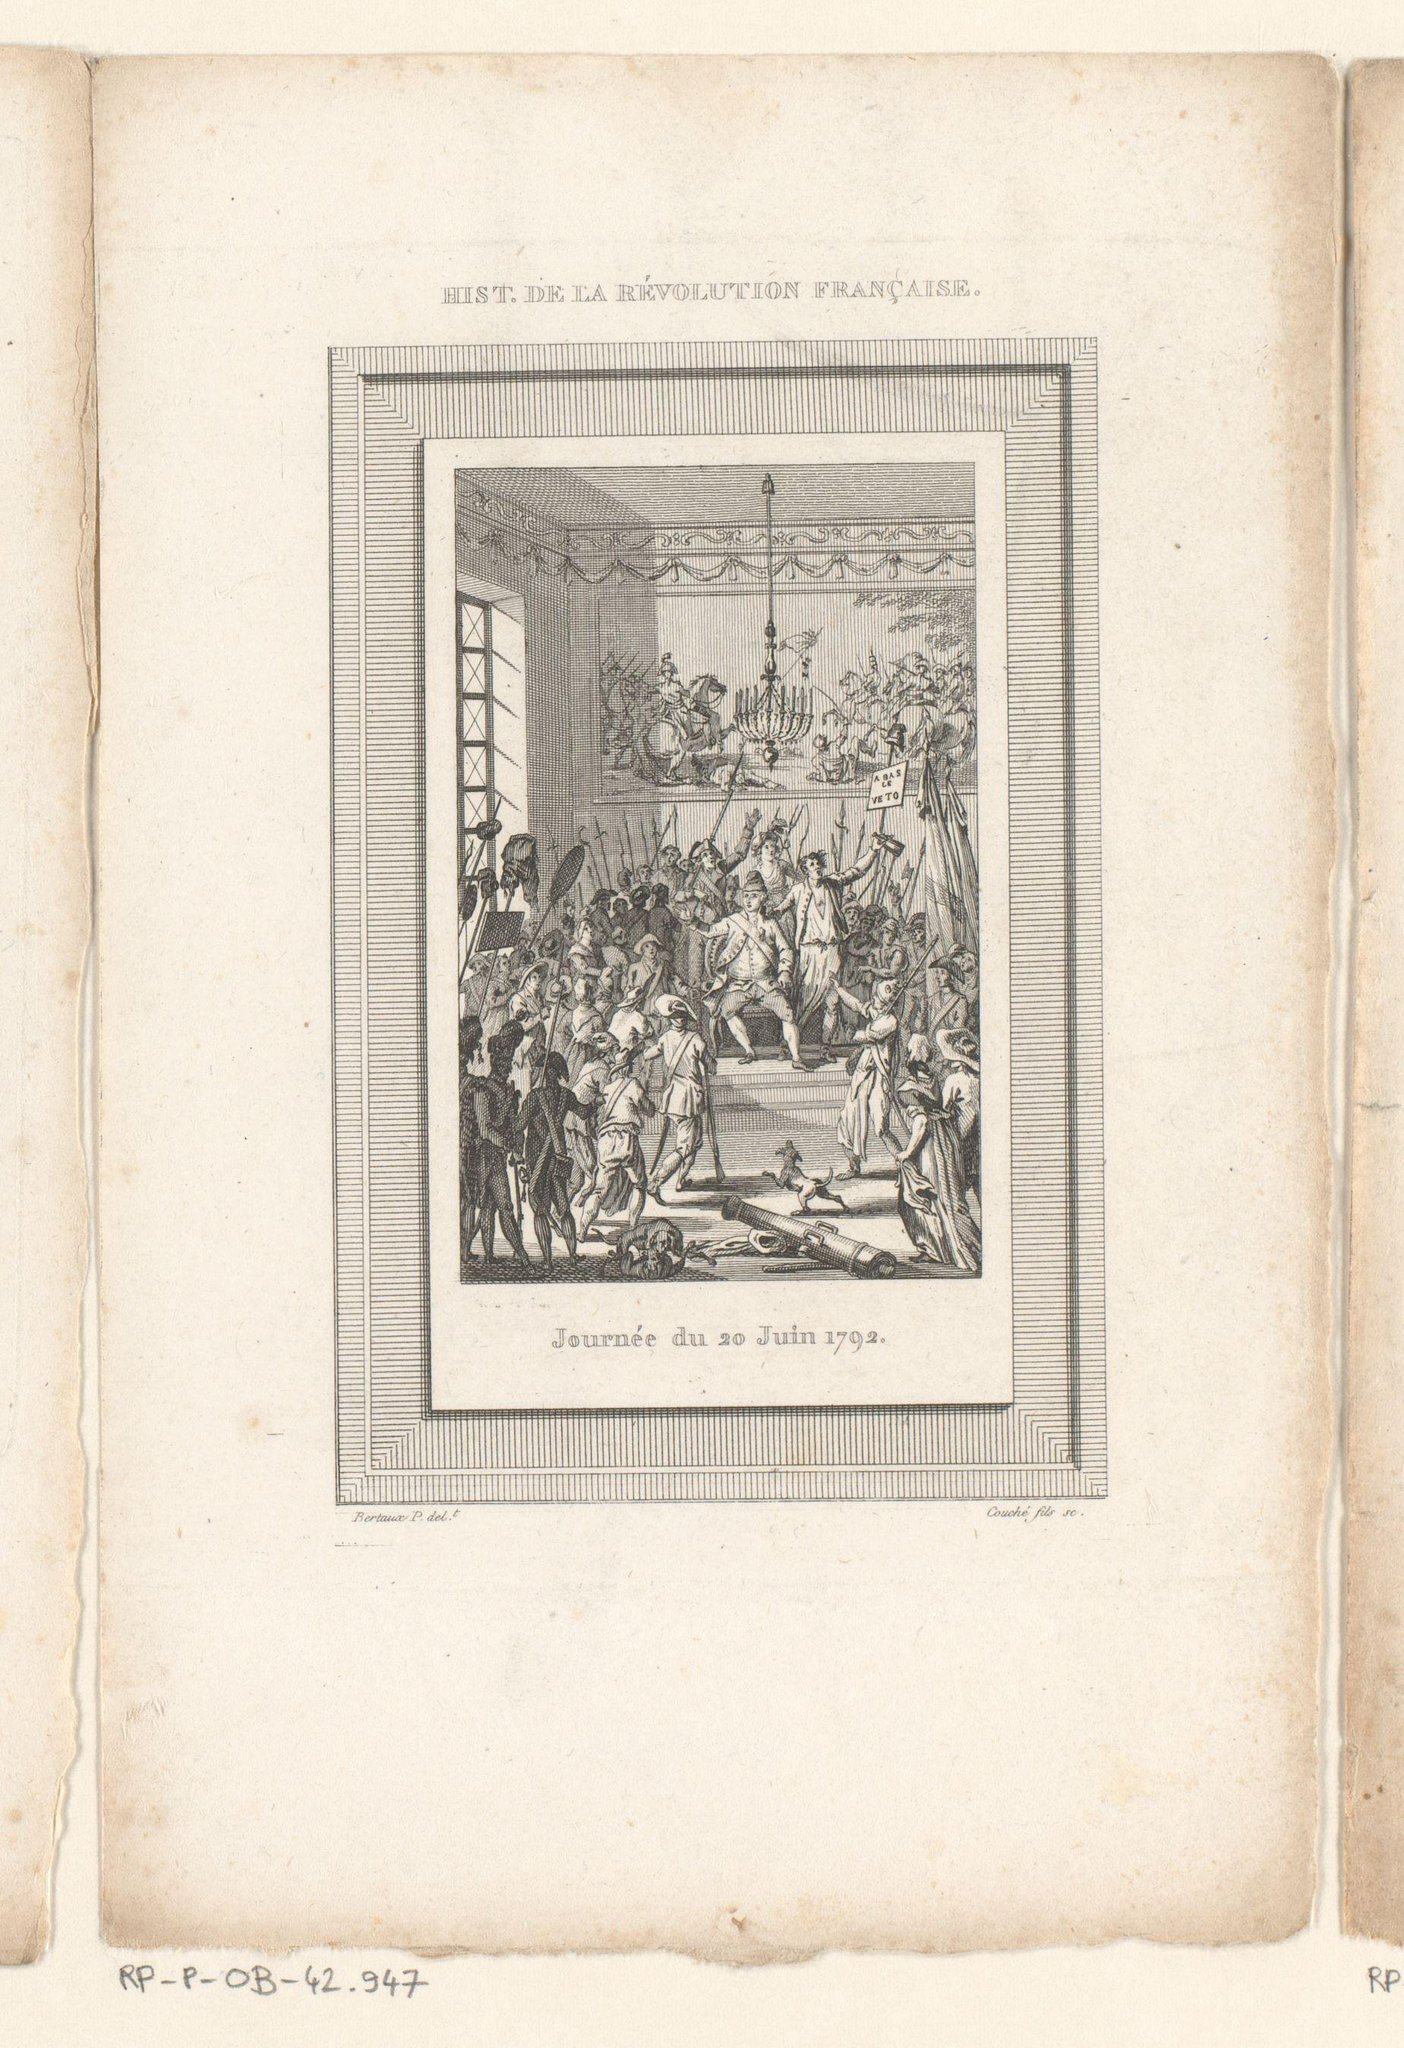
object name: print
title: Histoire de la Révolution Française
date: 1792-1849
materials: paper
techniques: etching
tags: political demonstration, revolution, revolt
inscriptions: collector's mark: Lugt 2228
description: Maakt deel uit van een serie getiteld 'Histoire de la Révolution Française' met belangrijke gebeurtenissen uit de Franse Revolutie.